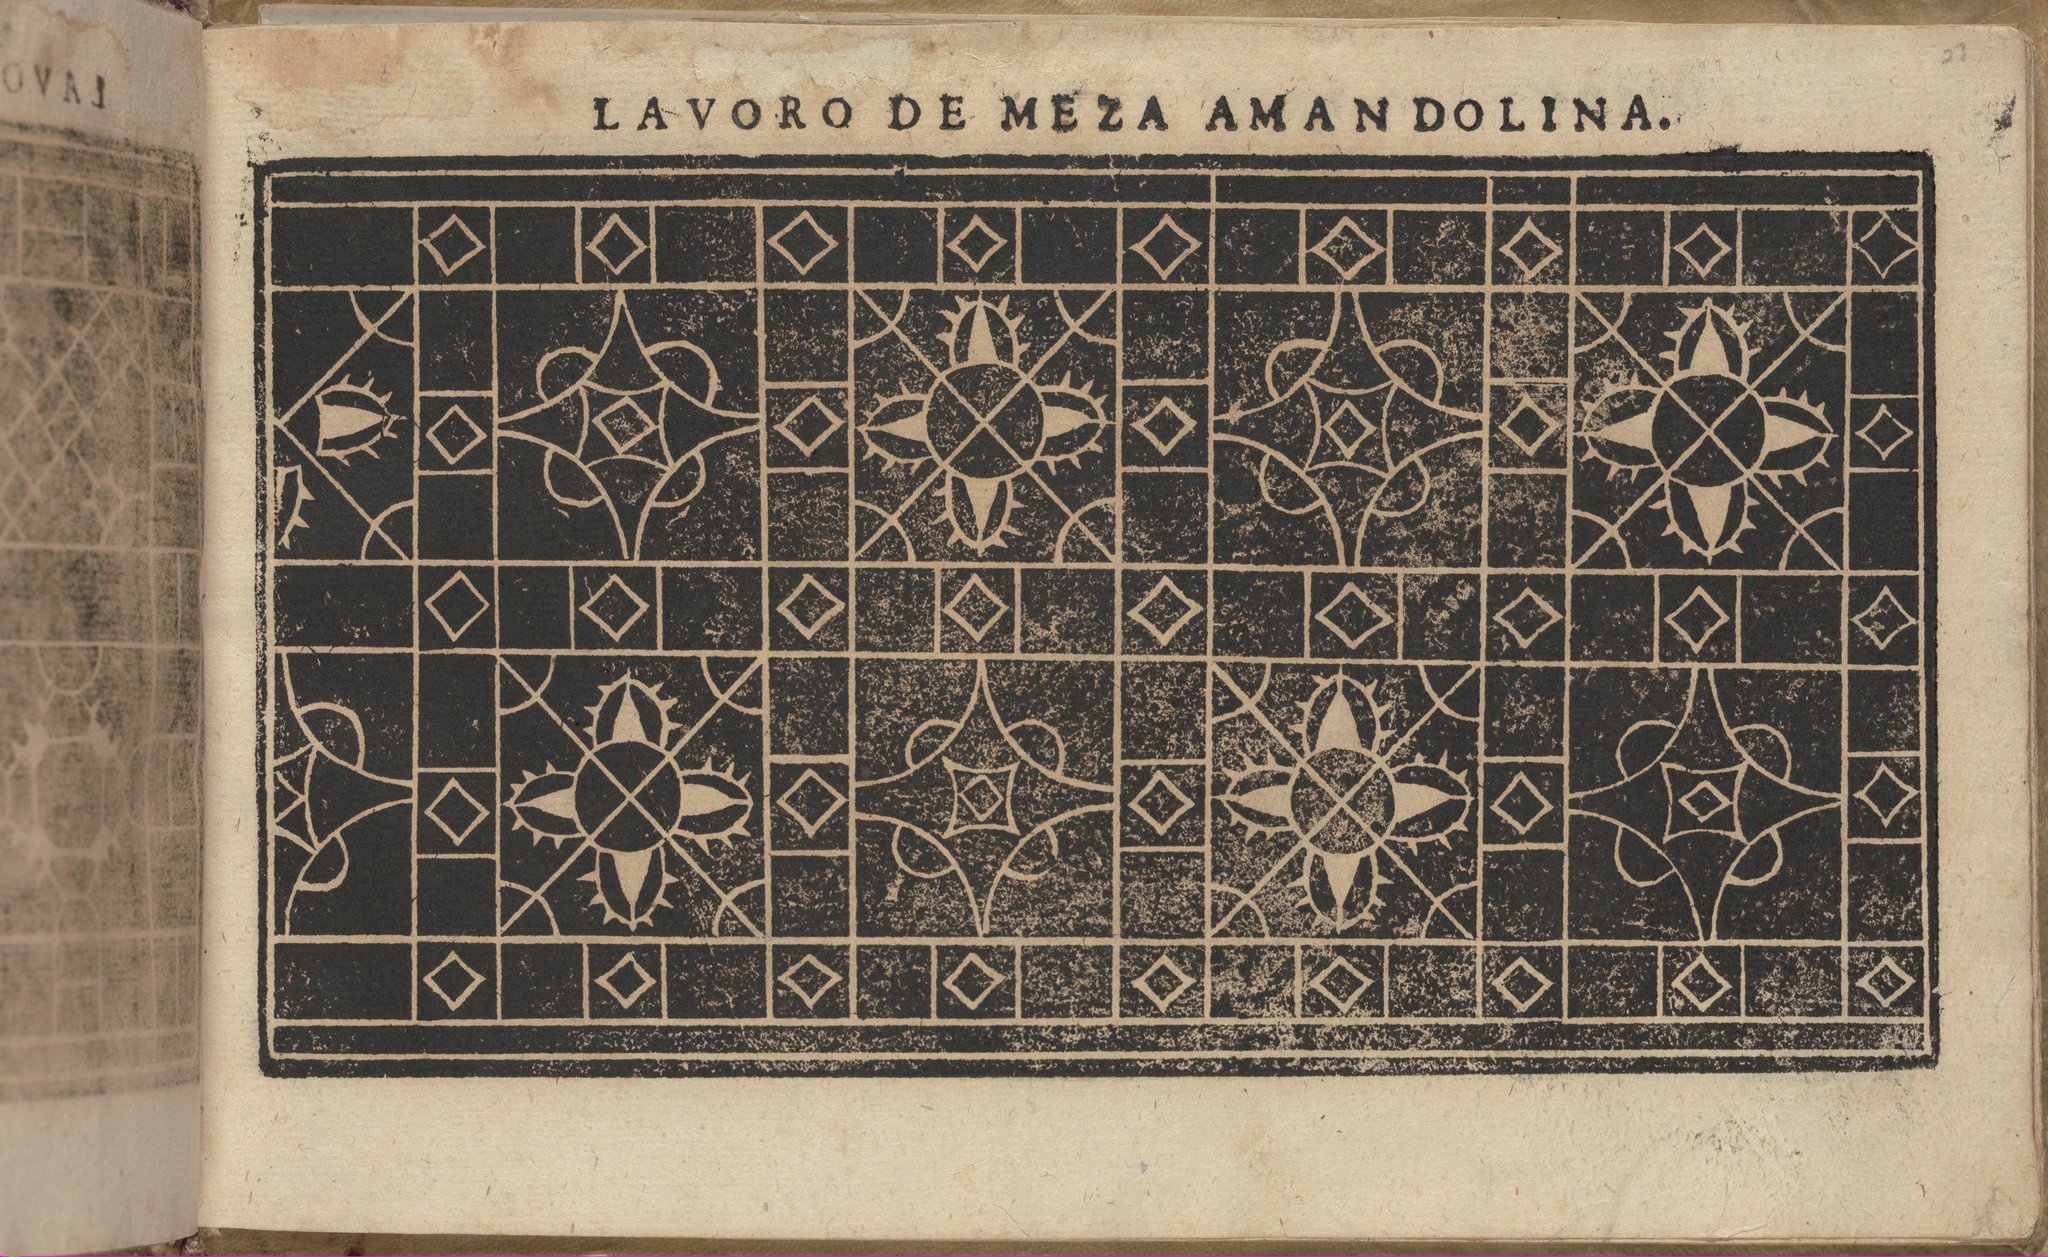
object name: book print ornament architecture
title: Studio delle virtuose Dame, page 27 (recto)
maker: isabella catanea parasole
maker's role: designer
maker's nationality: italian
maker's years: 1565-1625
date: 1597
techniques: woodcut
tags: ornament